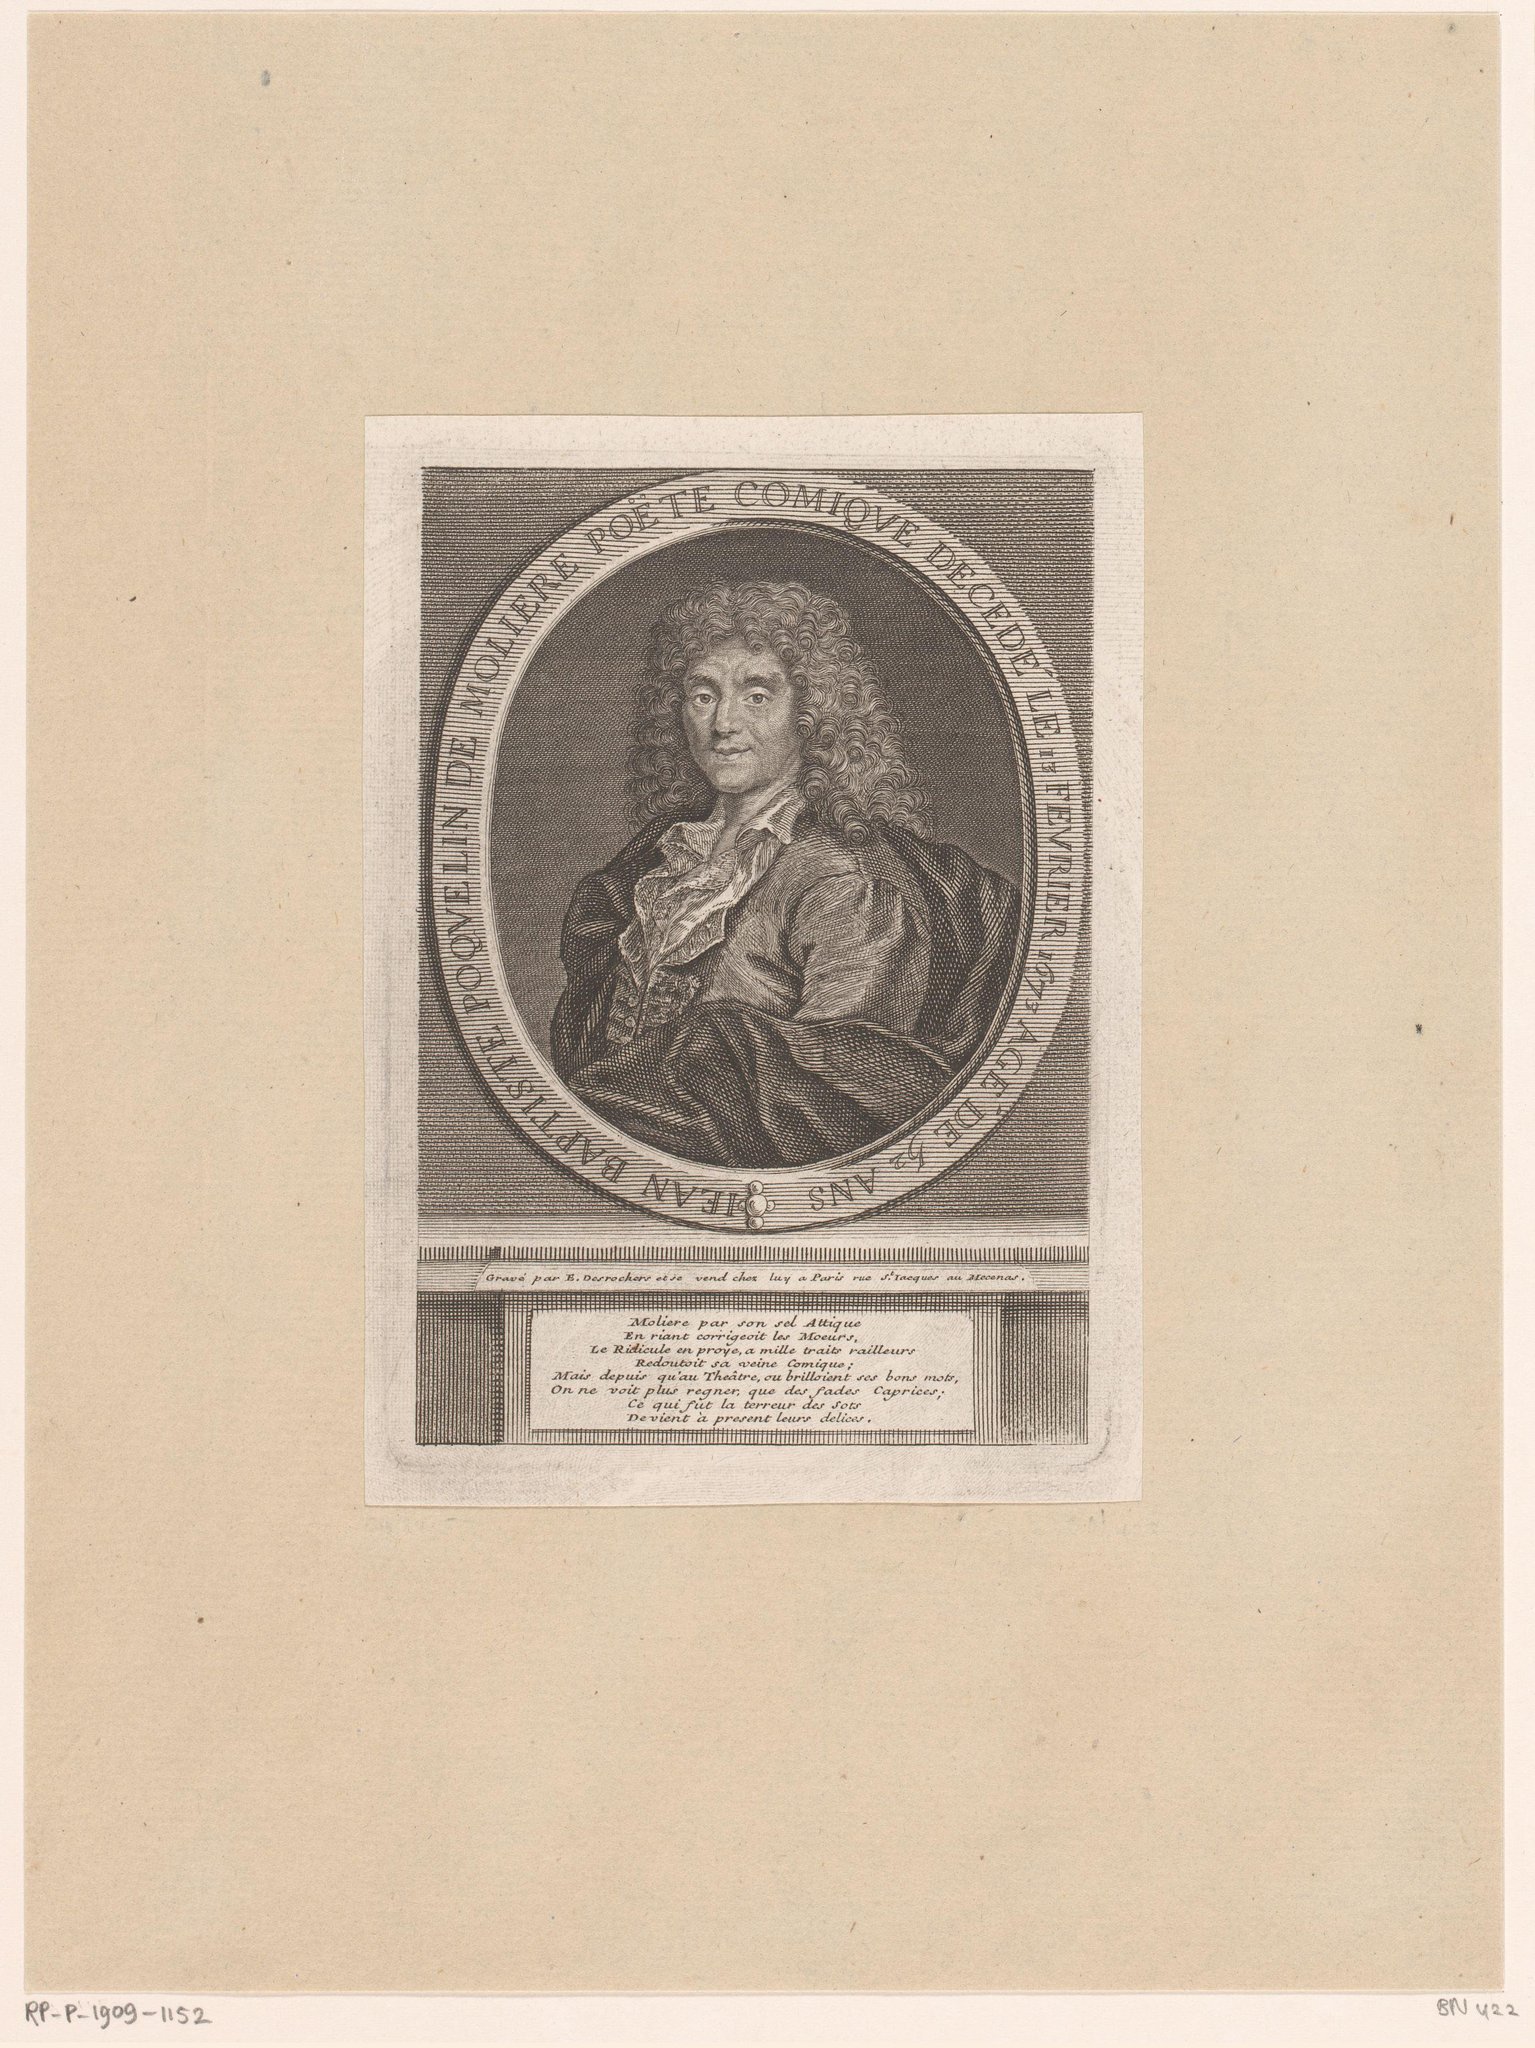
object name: print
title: Recueil de portraits (...)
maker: étienne desrochers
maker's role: print maker, publisher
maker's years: 1668-1741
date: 1726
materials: paper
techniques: engraving, etching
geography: paris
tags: paris, jean baptiste poquelin molière, historical persons, portrait of a writer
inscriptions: collector's mark: Lugt 2228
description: Behoort waarschijnlijk tot een serie portretten, grotendeels door Etienne Desrochers, getiteld: 'Recueil de portraits de personnes qui se sont distinguées tant dans les Armes que dans Belles-Lettres et les Arts, comme aussi la famille royale de France et autres cours étrangères'. De serie werd initieel uitgegeven door Desrochers en aangekondigd in 'Mercure' in mei 1726, p. 985. Echter was Desrochers reeds enkele jaren eerder begonnen met het uitgeven van de serie. Na de dood van Desrochers werd de serie voortgezet door Gilles Edme Petit. Een latere staat werd uitgegeven door Jean François Daumont in Parijs.